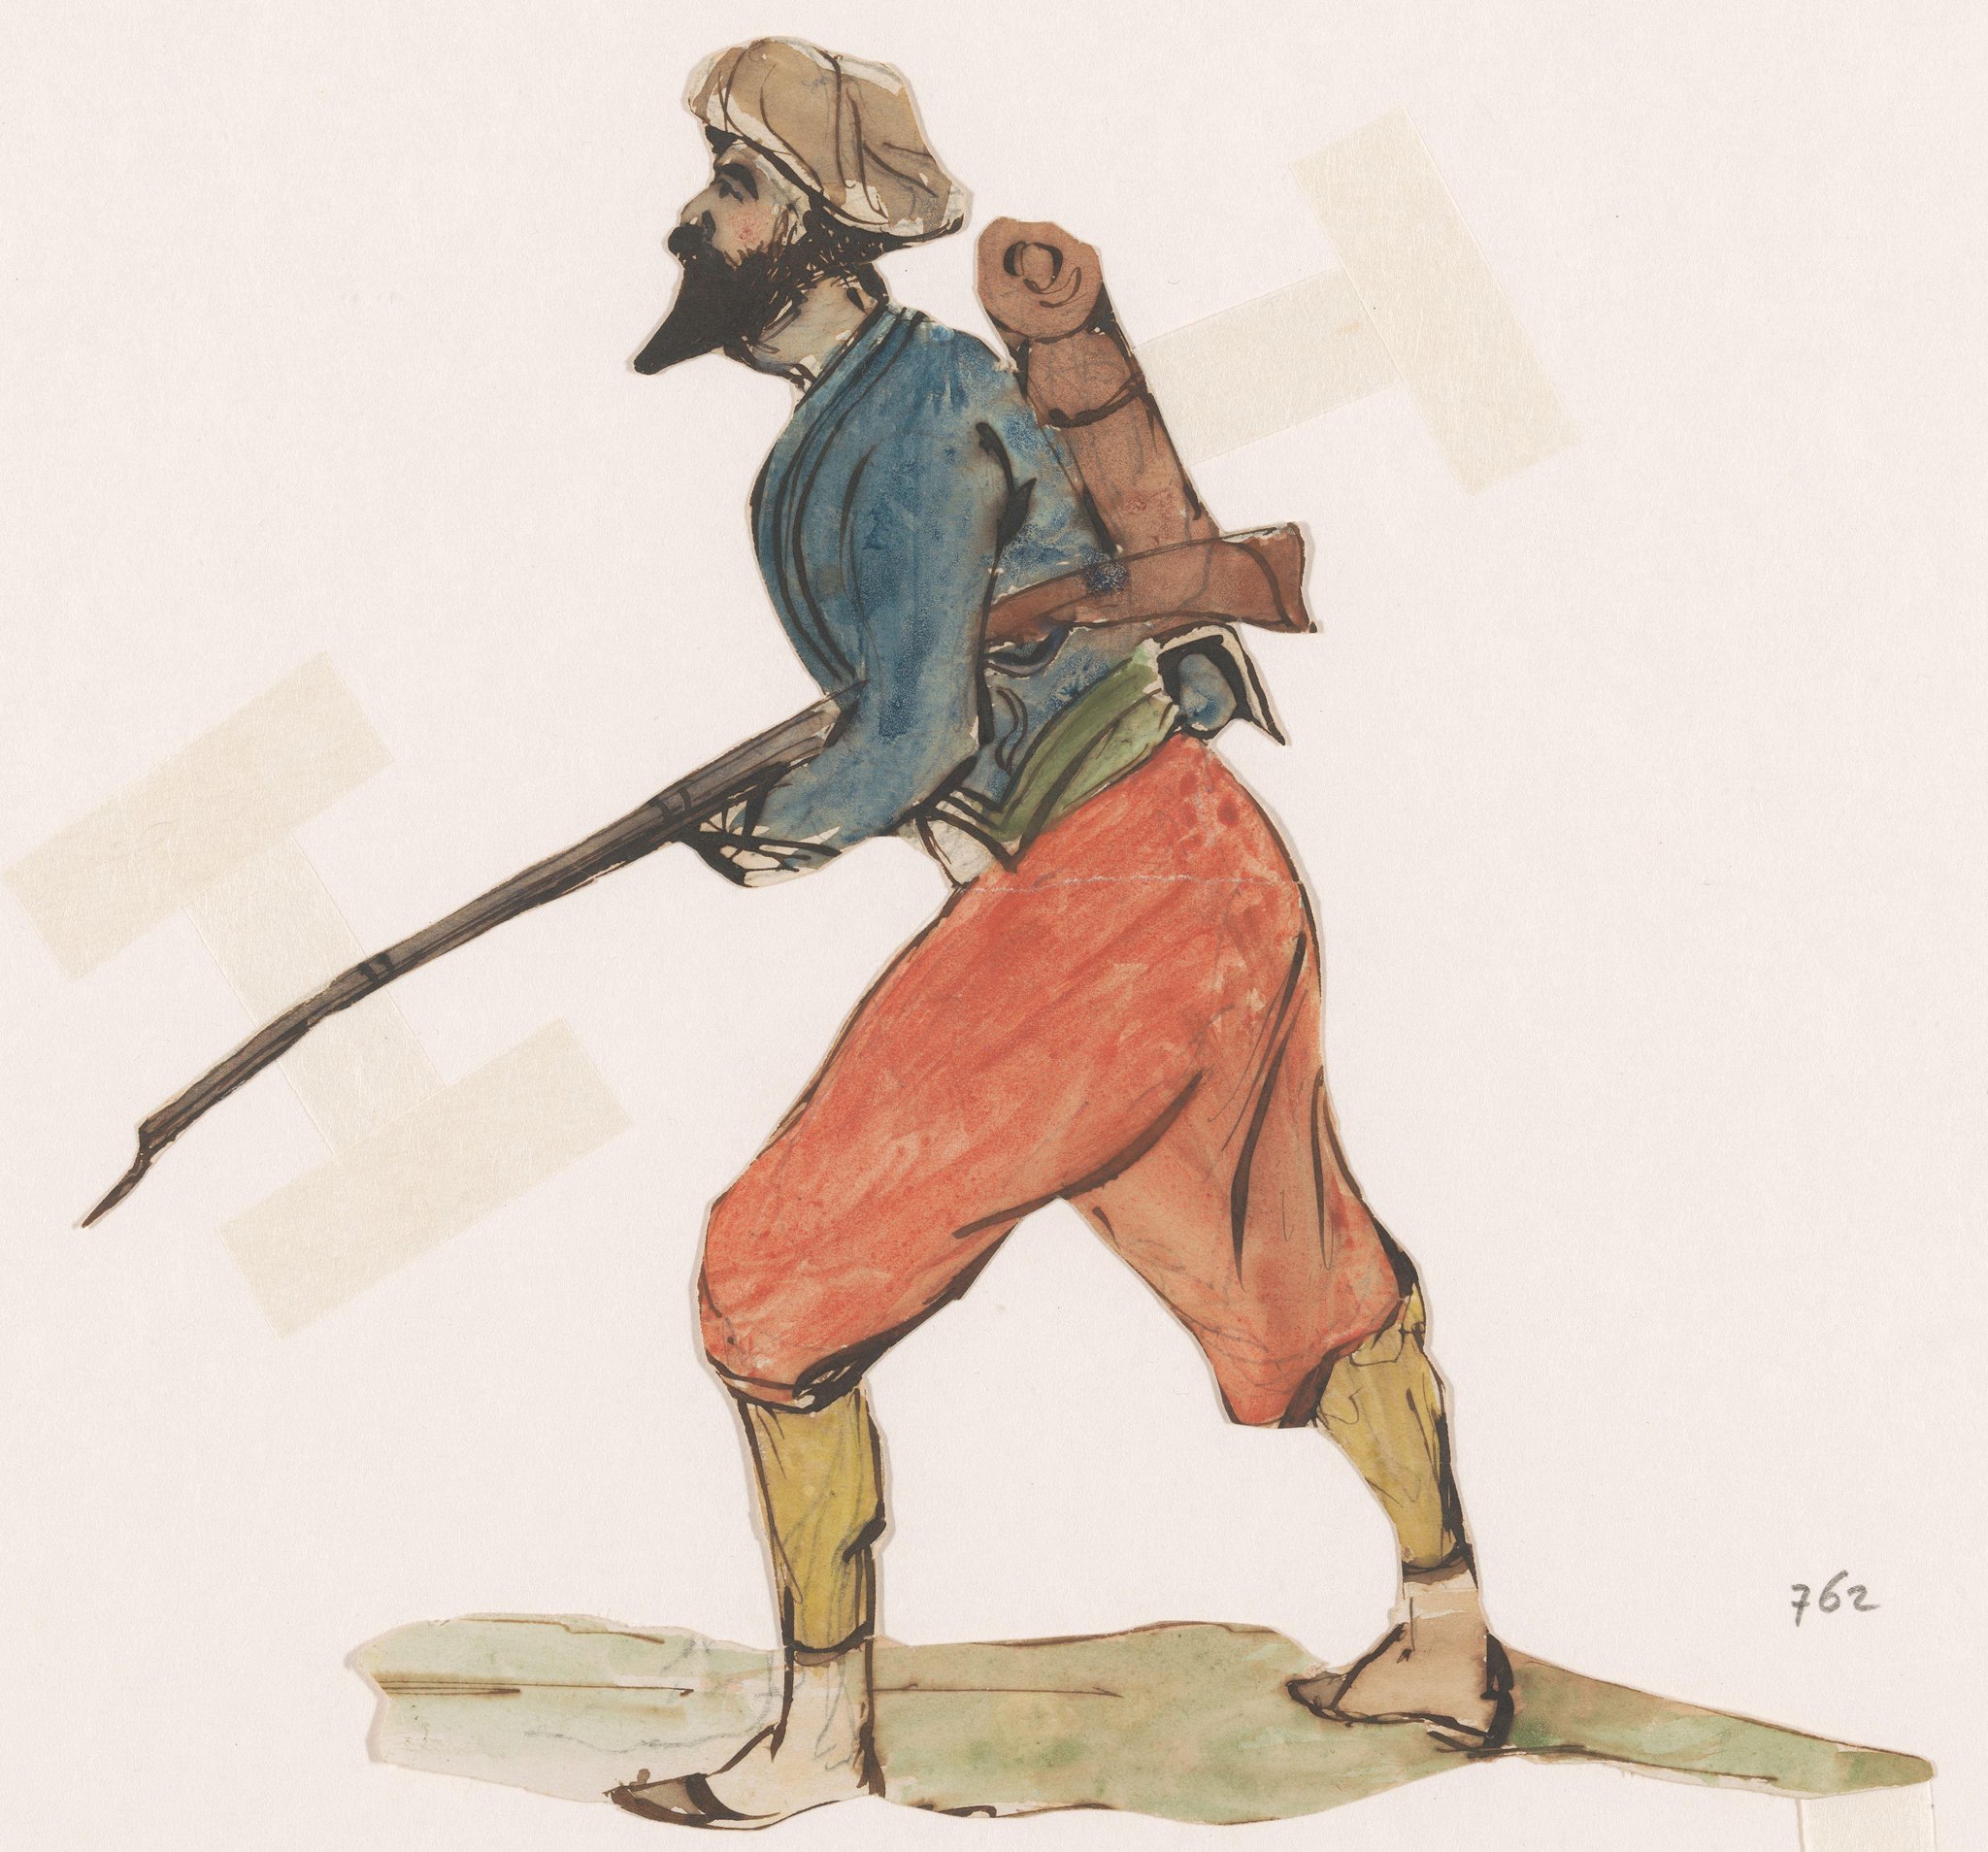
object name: drawing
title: Soldaat met baard en geweer, tulband op het hoofd, rode broek en ransel op de rug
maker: johannes tavenraat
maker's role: draughtsman, painter, print maker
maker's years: 1809-1881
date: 1840-1880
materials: ink, paper, pencil, watercolor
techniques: brush, pen, snipping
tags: warfare; military affairs (+ infantry), the soldier; the soldier's life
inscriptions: collector's mark: Lugt 2228